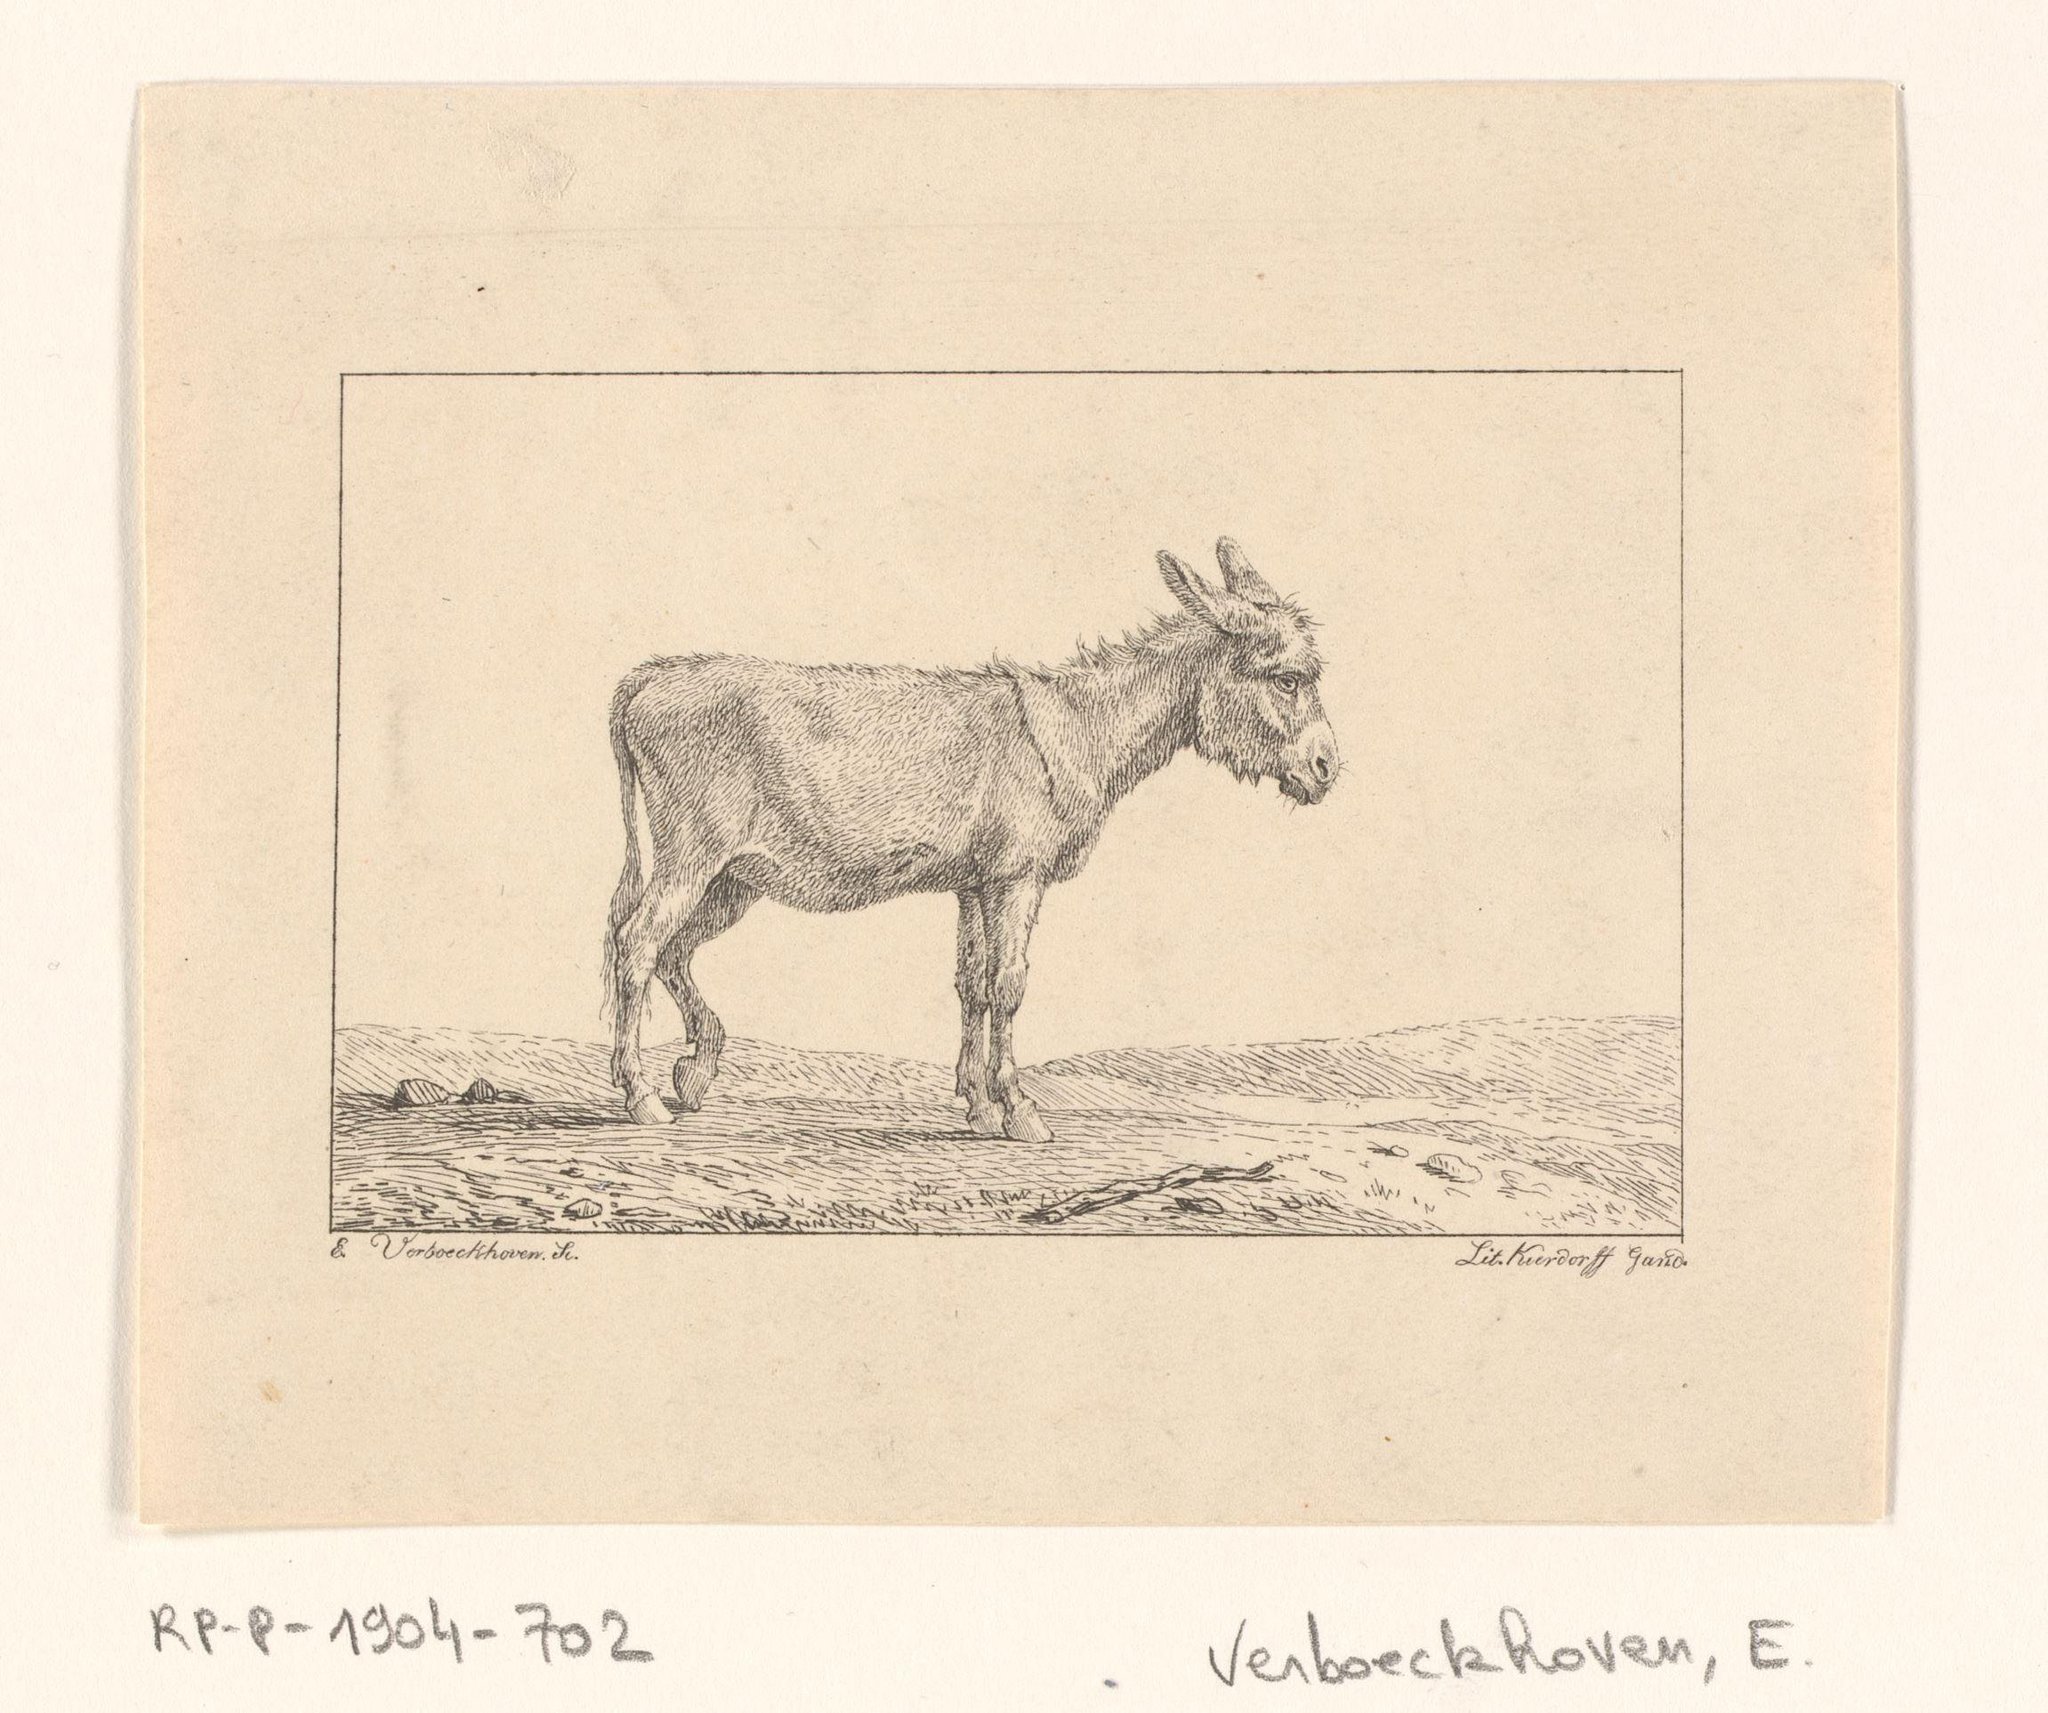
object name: print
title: Staande ezel naar rechts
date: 1822-1830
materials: paper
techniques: lithograph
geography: ghent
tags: ass, donkey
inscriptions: collector's mark: Lugt 1485